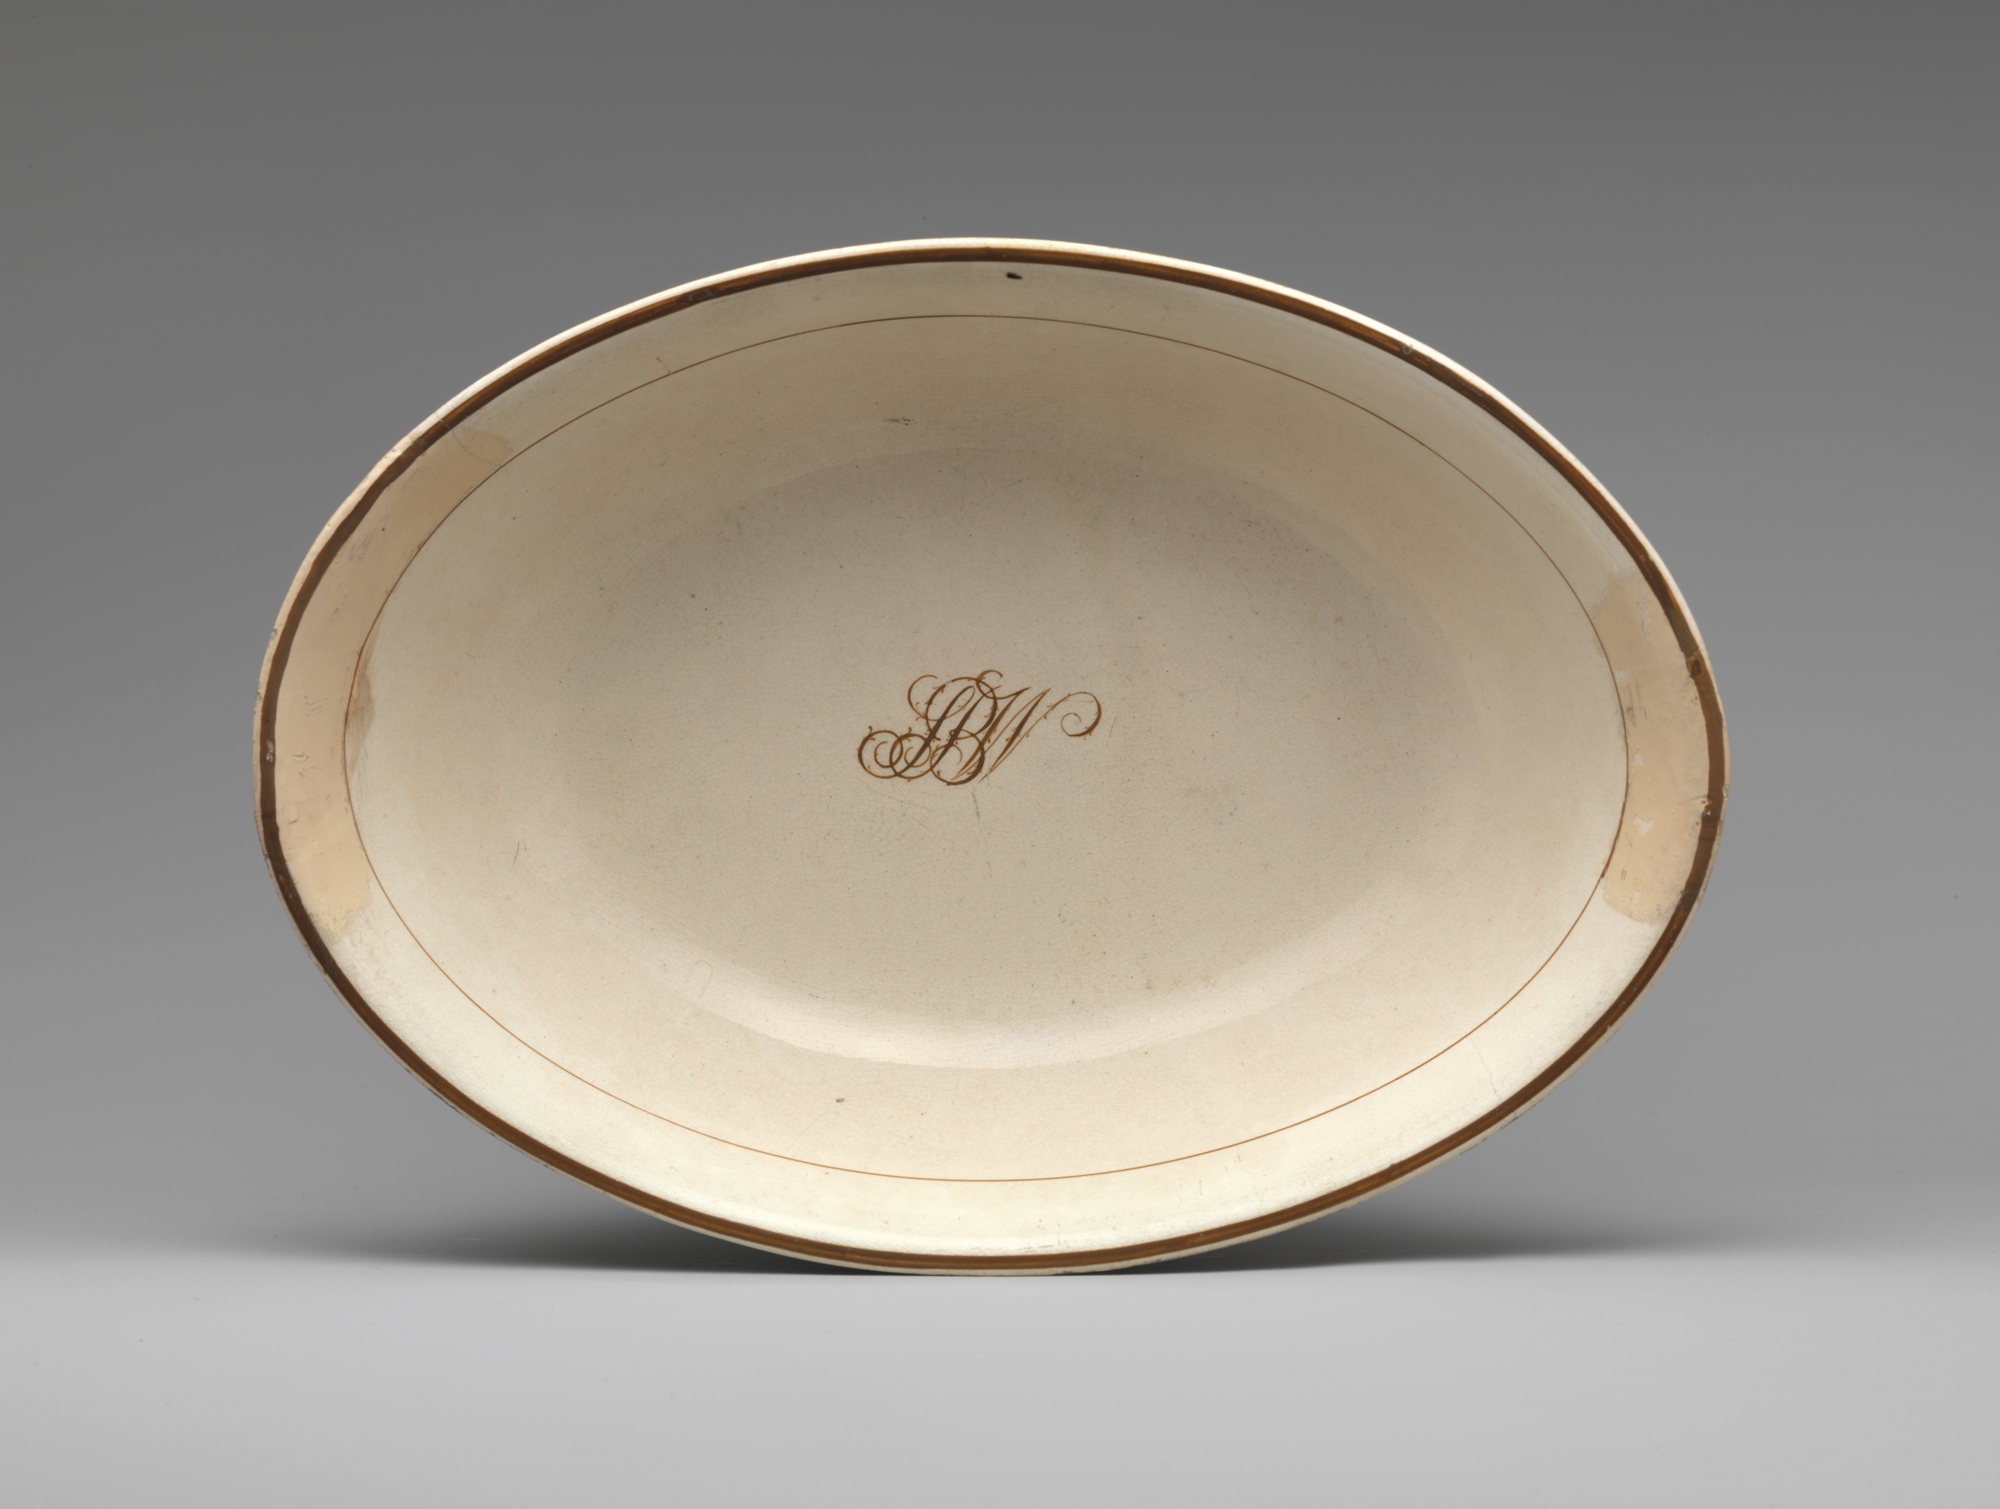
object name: dish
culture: british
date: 1750-1775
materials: earthenware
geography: england